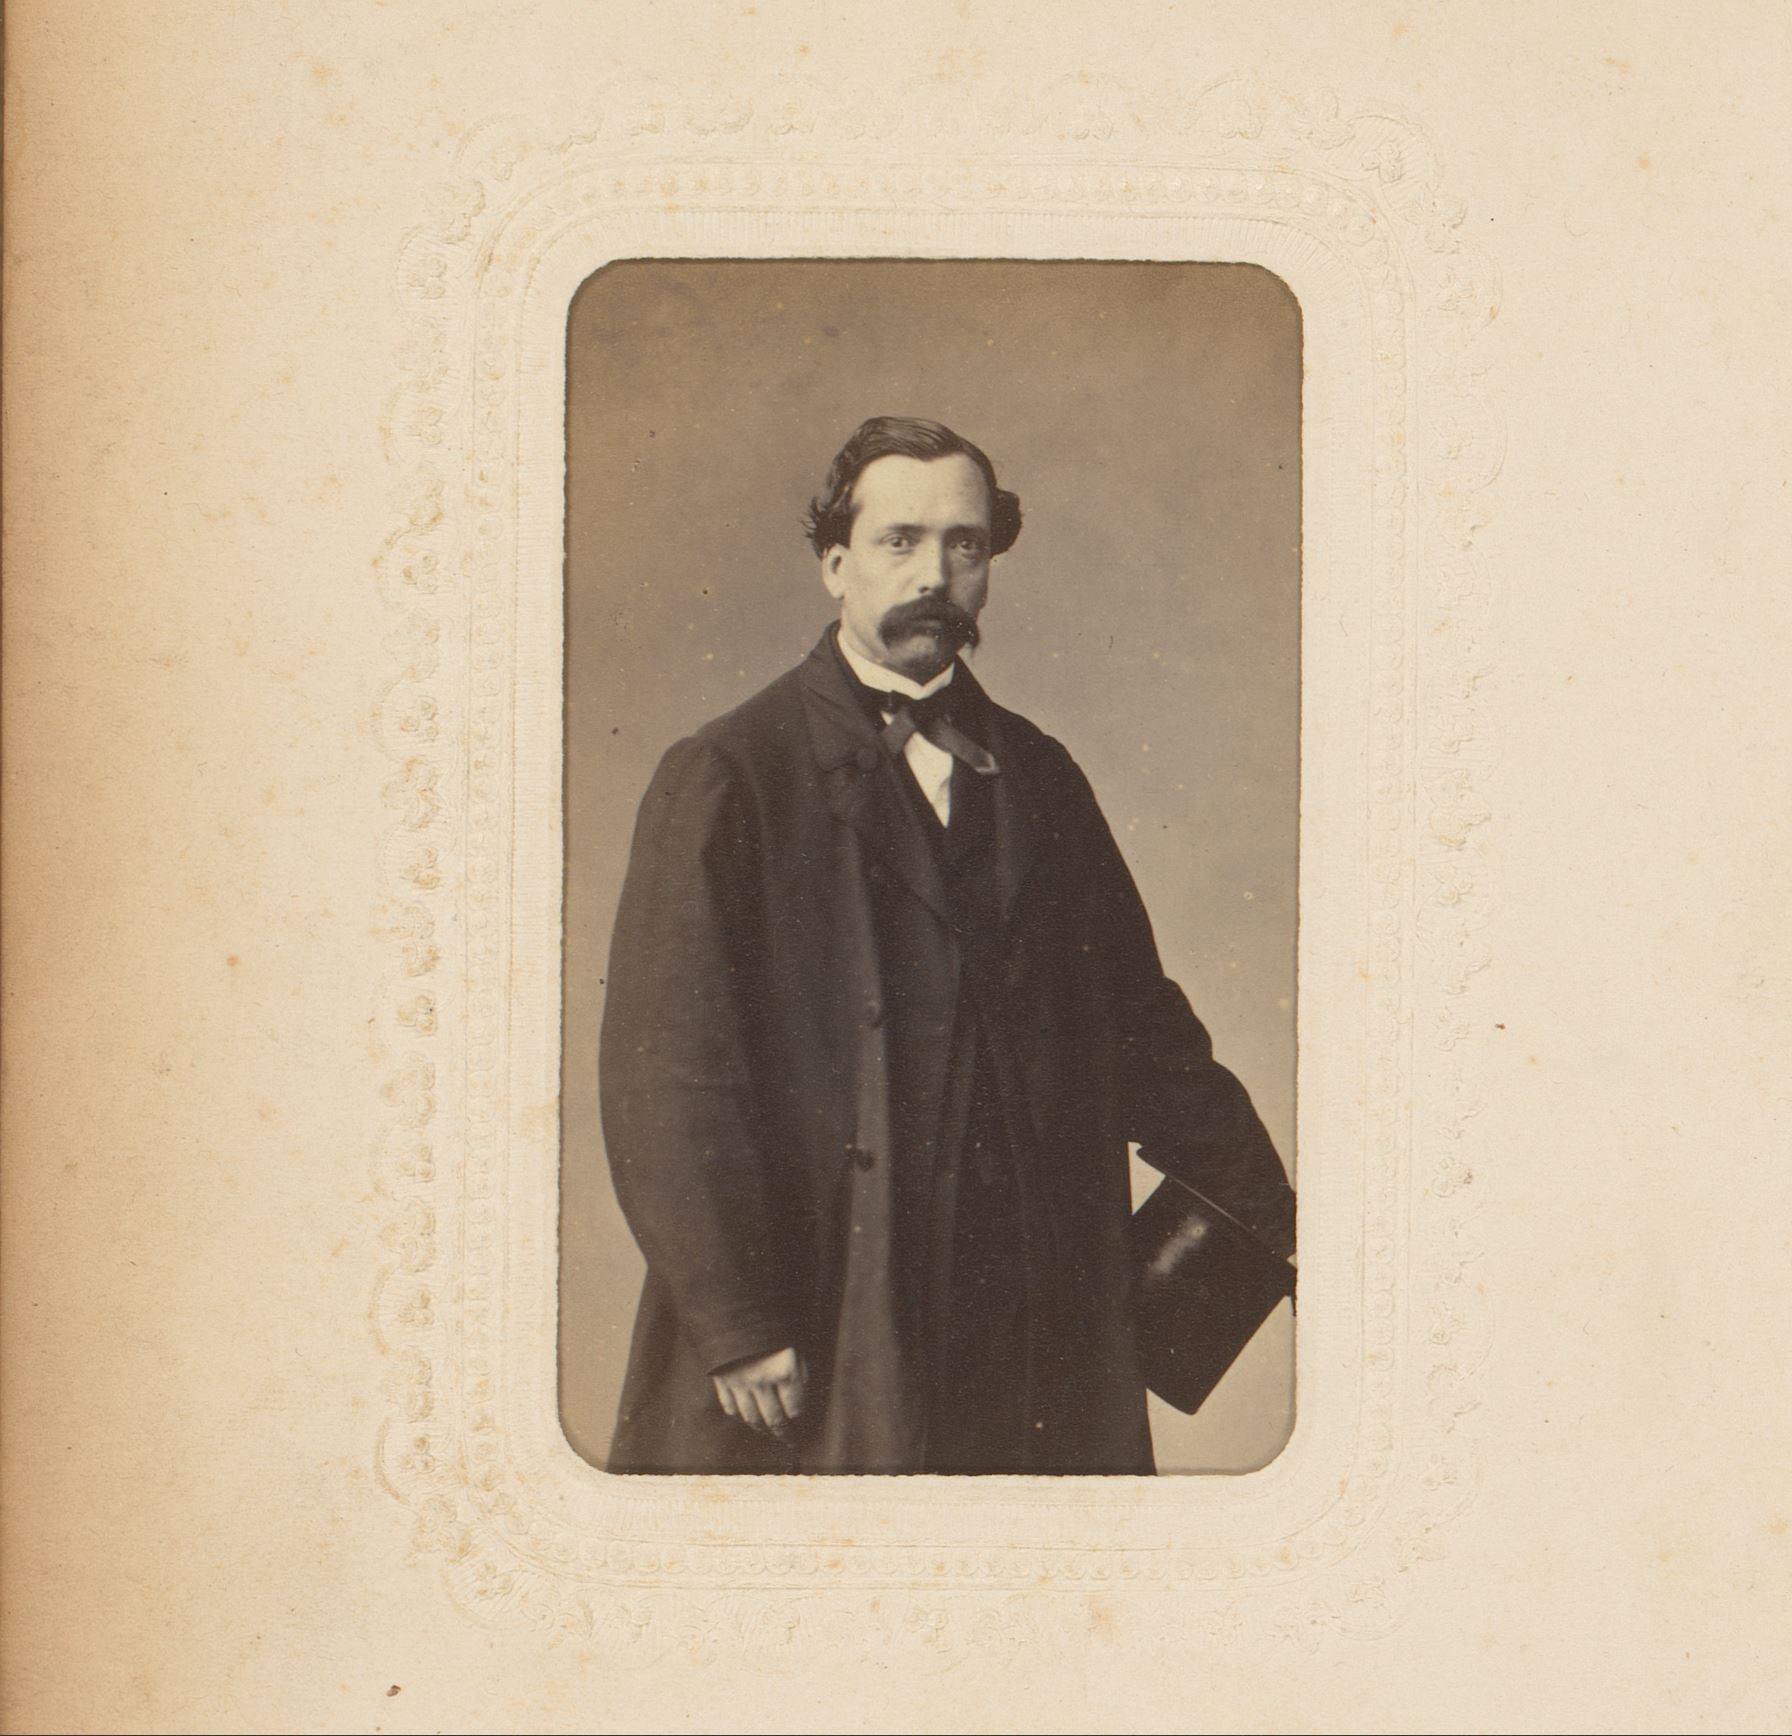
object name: carte de visite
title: Portret van een man met snor en hoed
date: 1862-1863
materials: cardboard, photographic support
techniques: albumen print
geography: brussels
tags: moustache, historical persons, head-gear: top hat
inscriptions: inscription: ‘Etablissement Photographique/ de Maes & Michaux/ Place de la Monnaie, 36, Rue Fossé-aux-Loups/ Bruxelles’